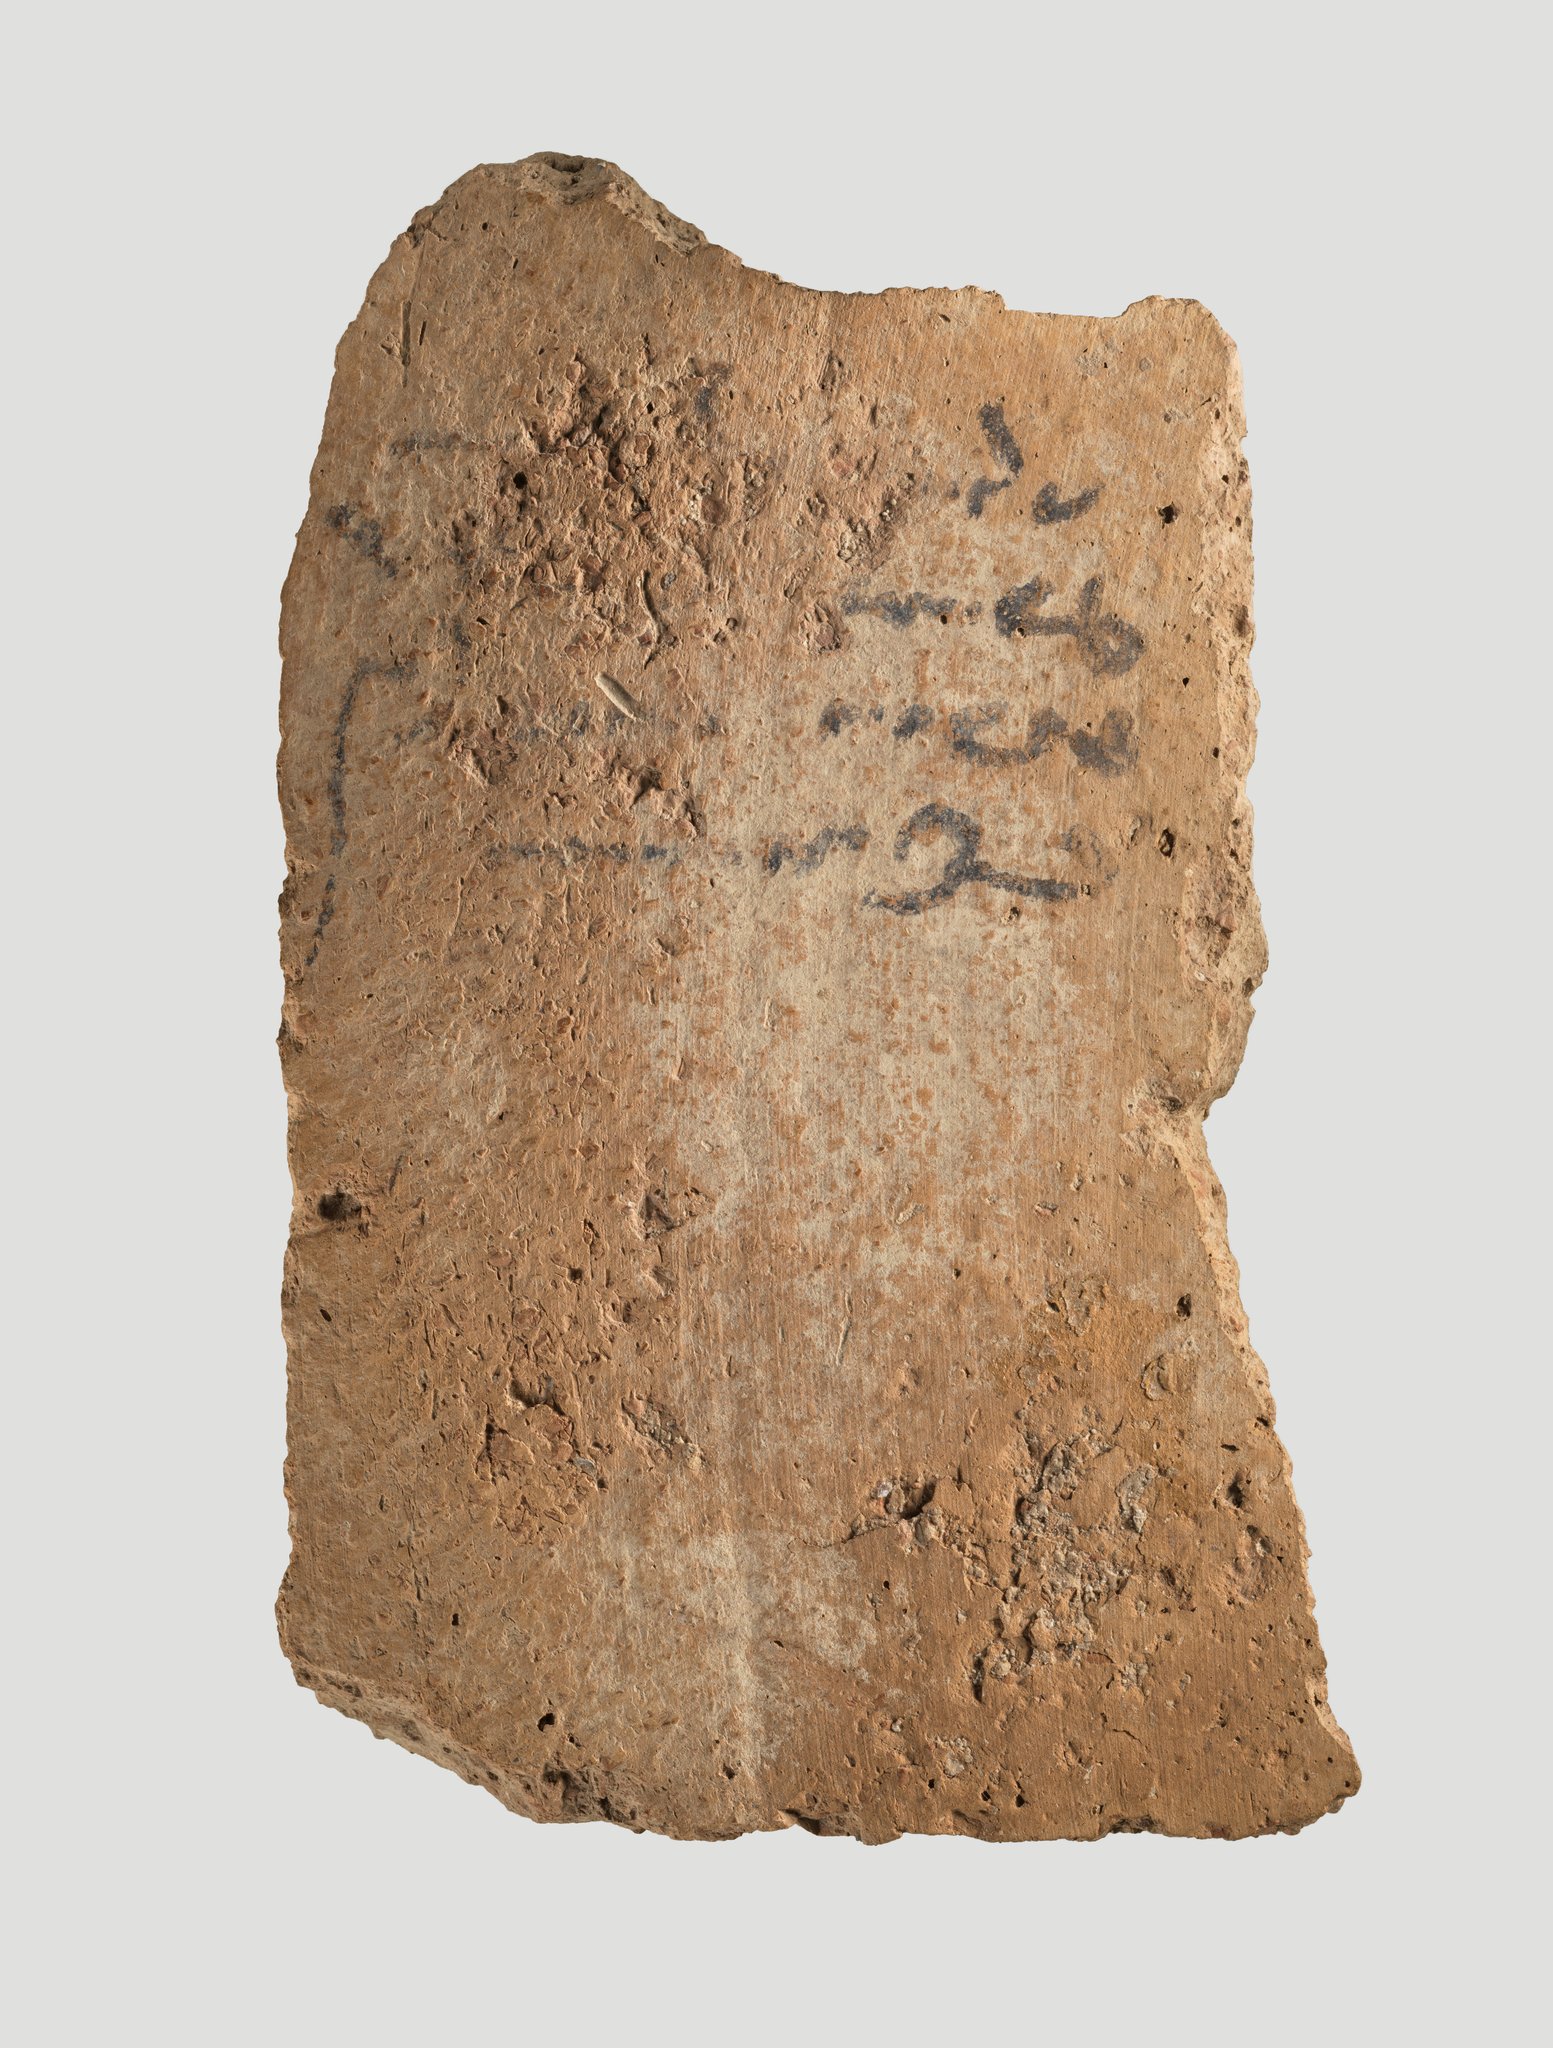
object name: sherd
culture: sasanian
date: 201-700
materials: ceramic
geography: iran